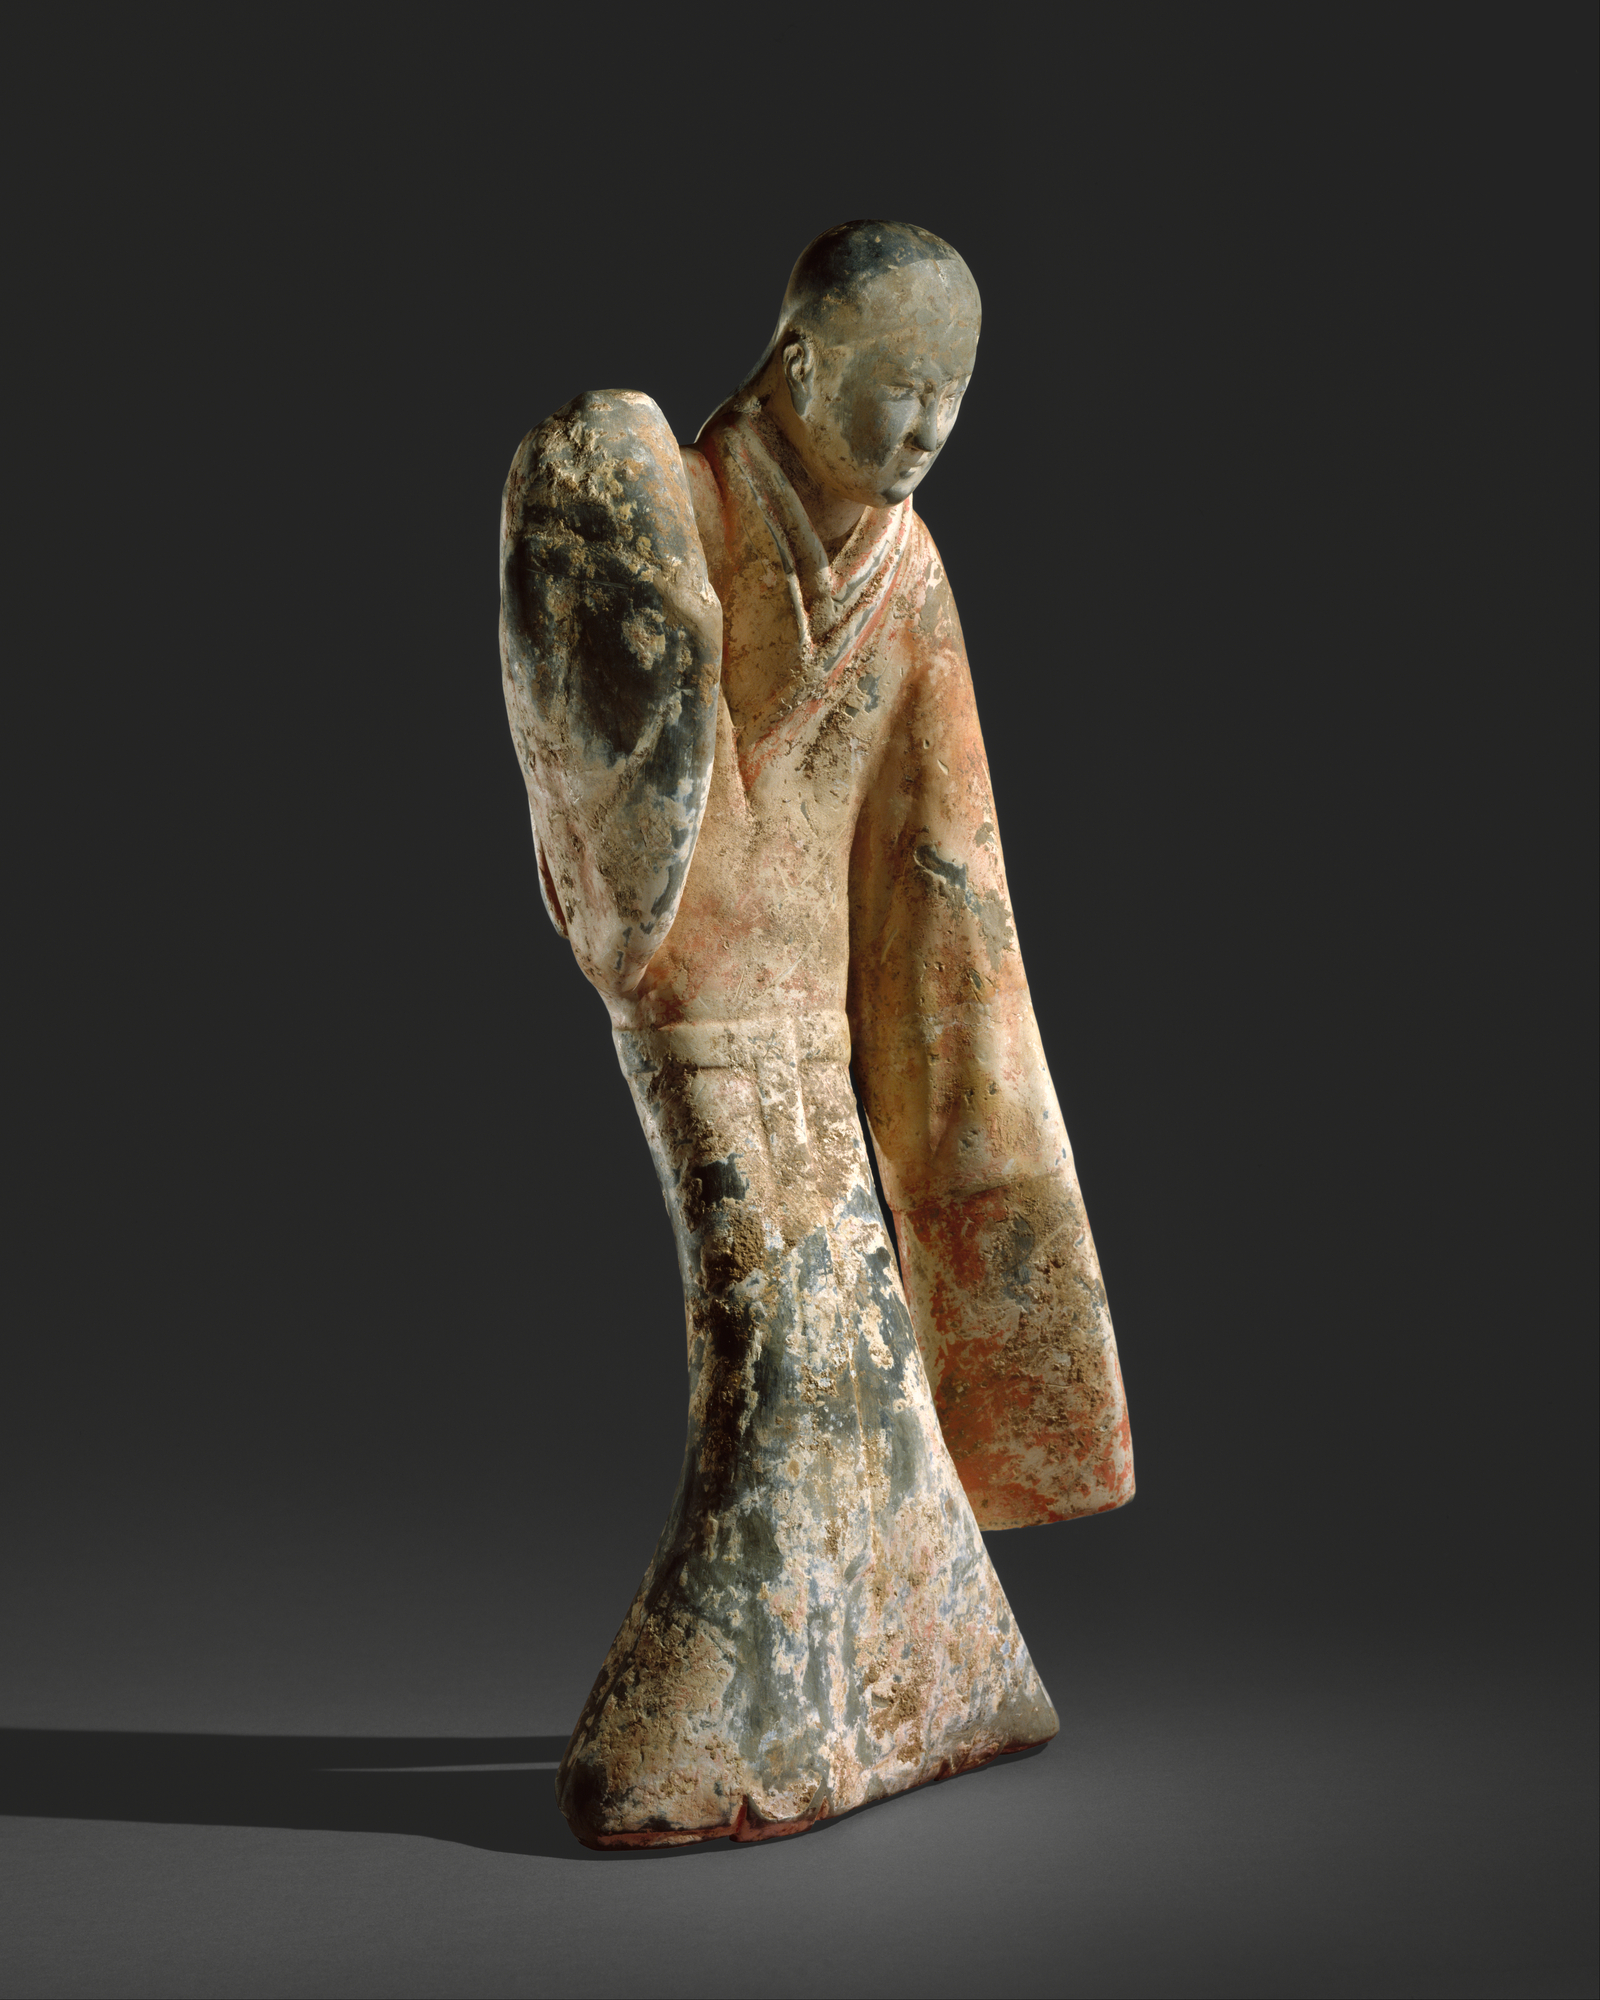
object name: figure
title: Female Dancer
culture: chinese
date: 200-101 BCE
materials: earthenware, pigment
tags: women,dancers